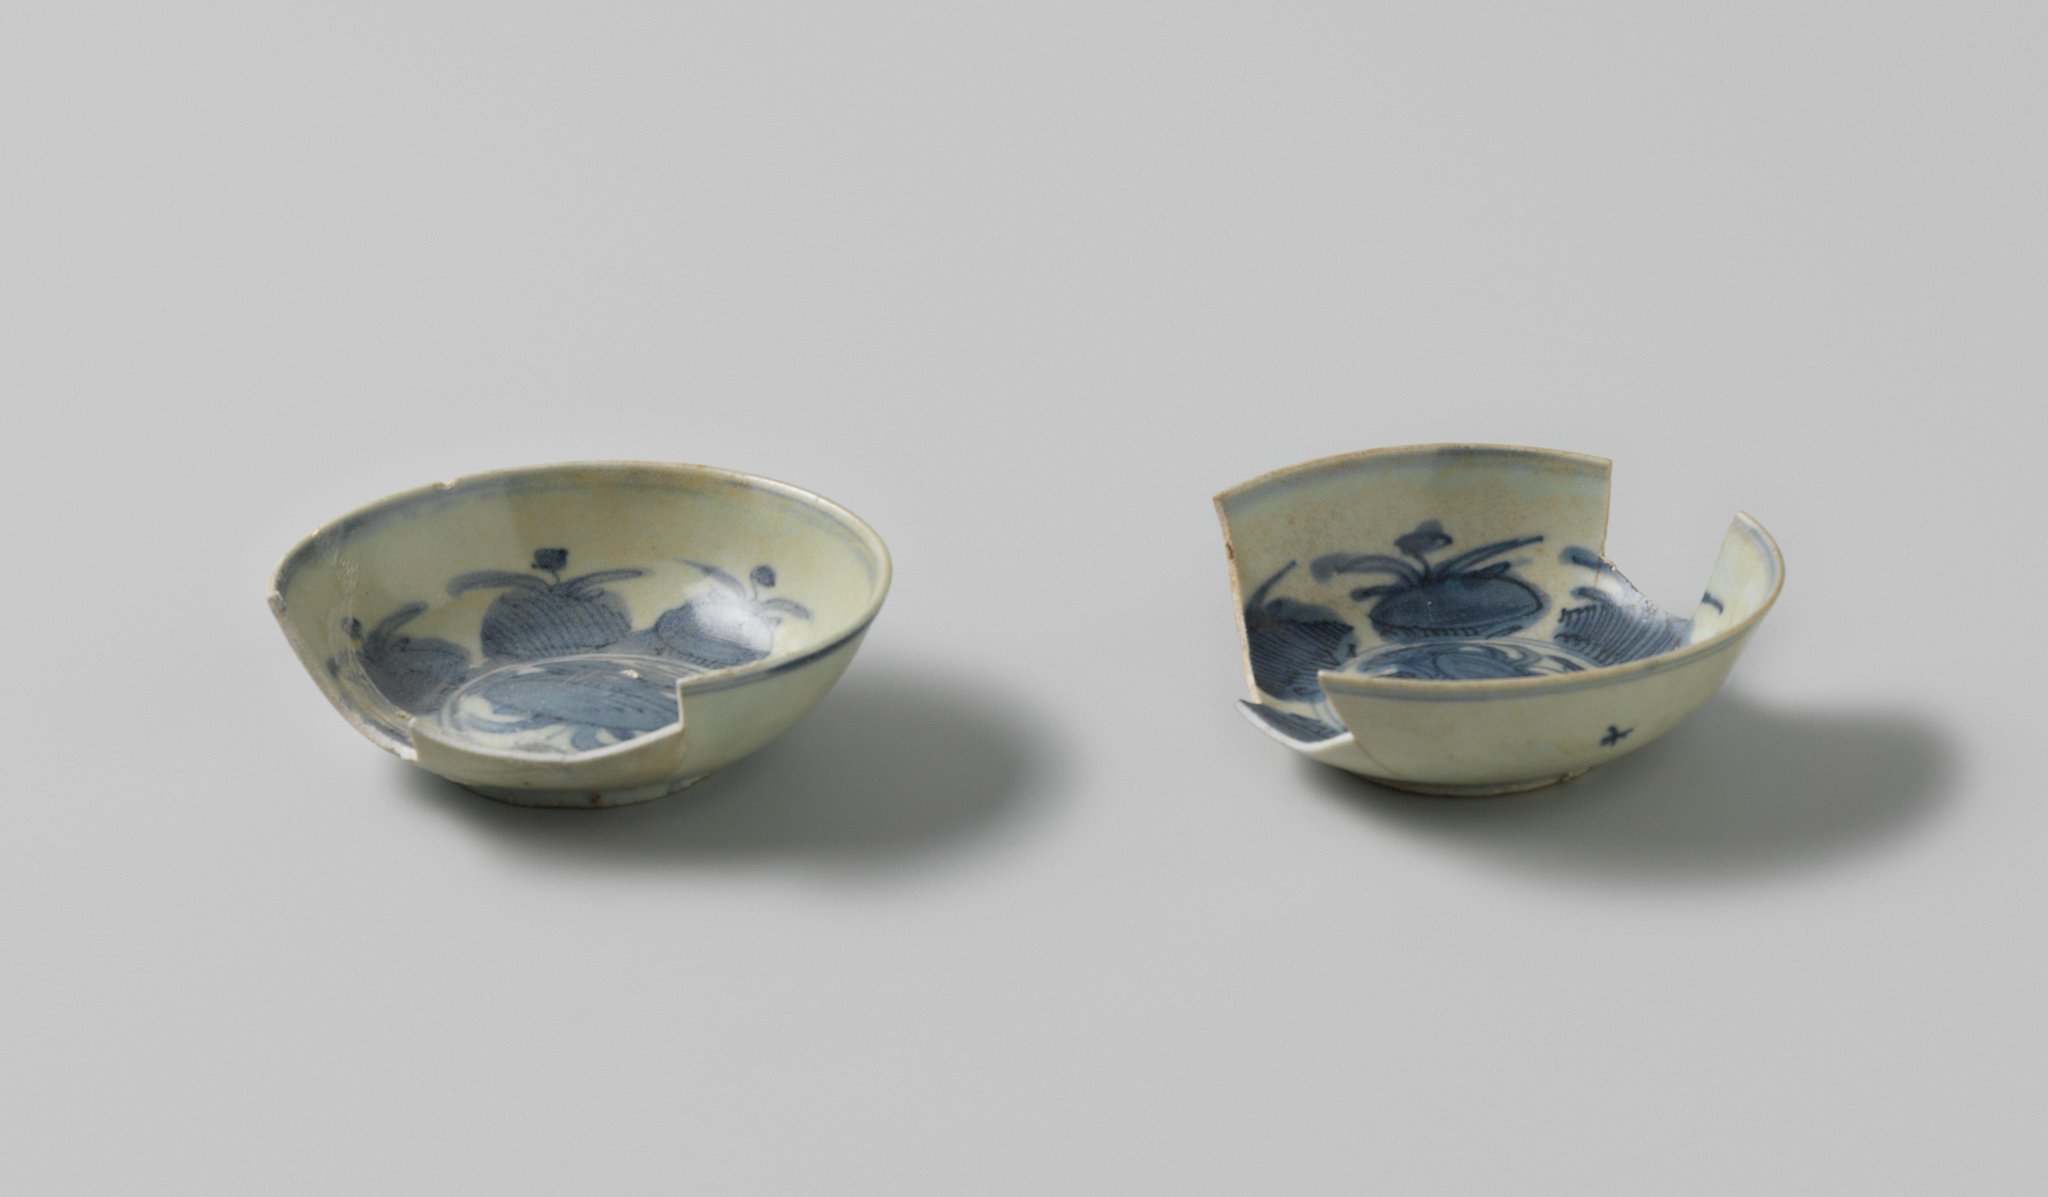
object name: platter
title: Soucer of Chinese porcelain from the wreck of the Dutch East Indiaman Witte Leeuw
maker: Anonymous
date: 1613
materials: porcelain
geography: jingdezhen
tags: verenigde oostindische compagnie, sint-helena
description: Incomplete schotel van porselein uit V.O.C.-schip de 'Witte Leeuw'. Zie ook NG-1978-127-10518-2.